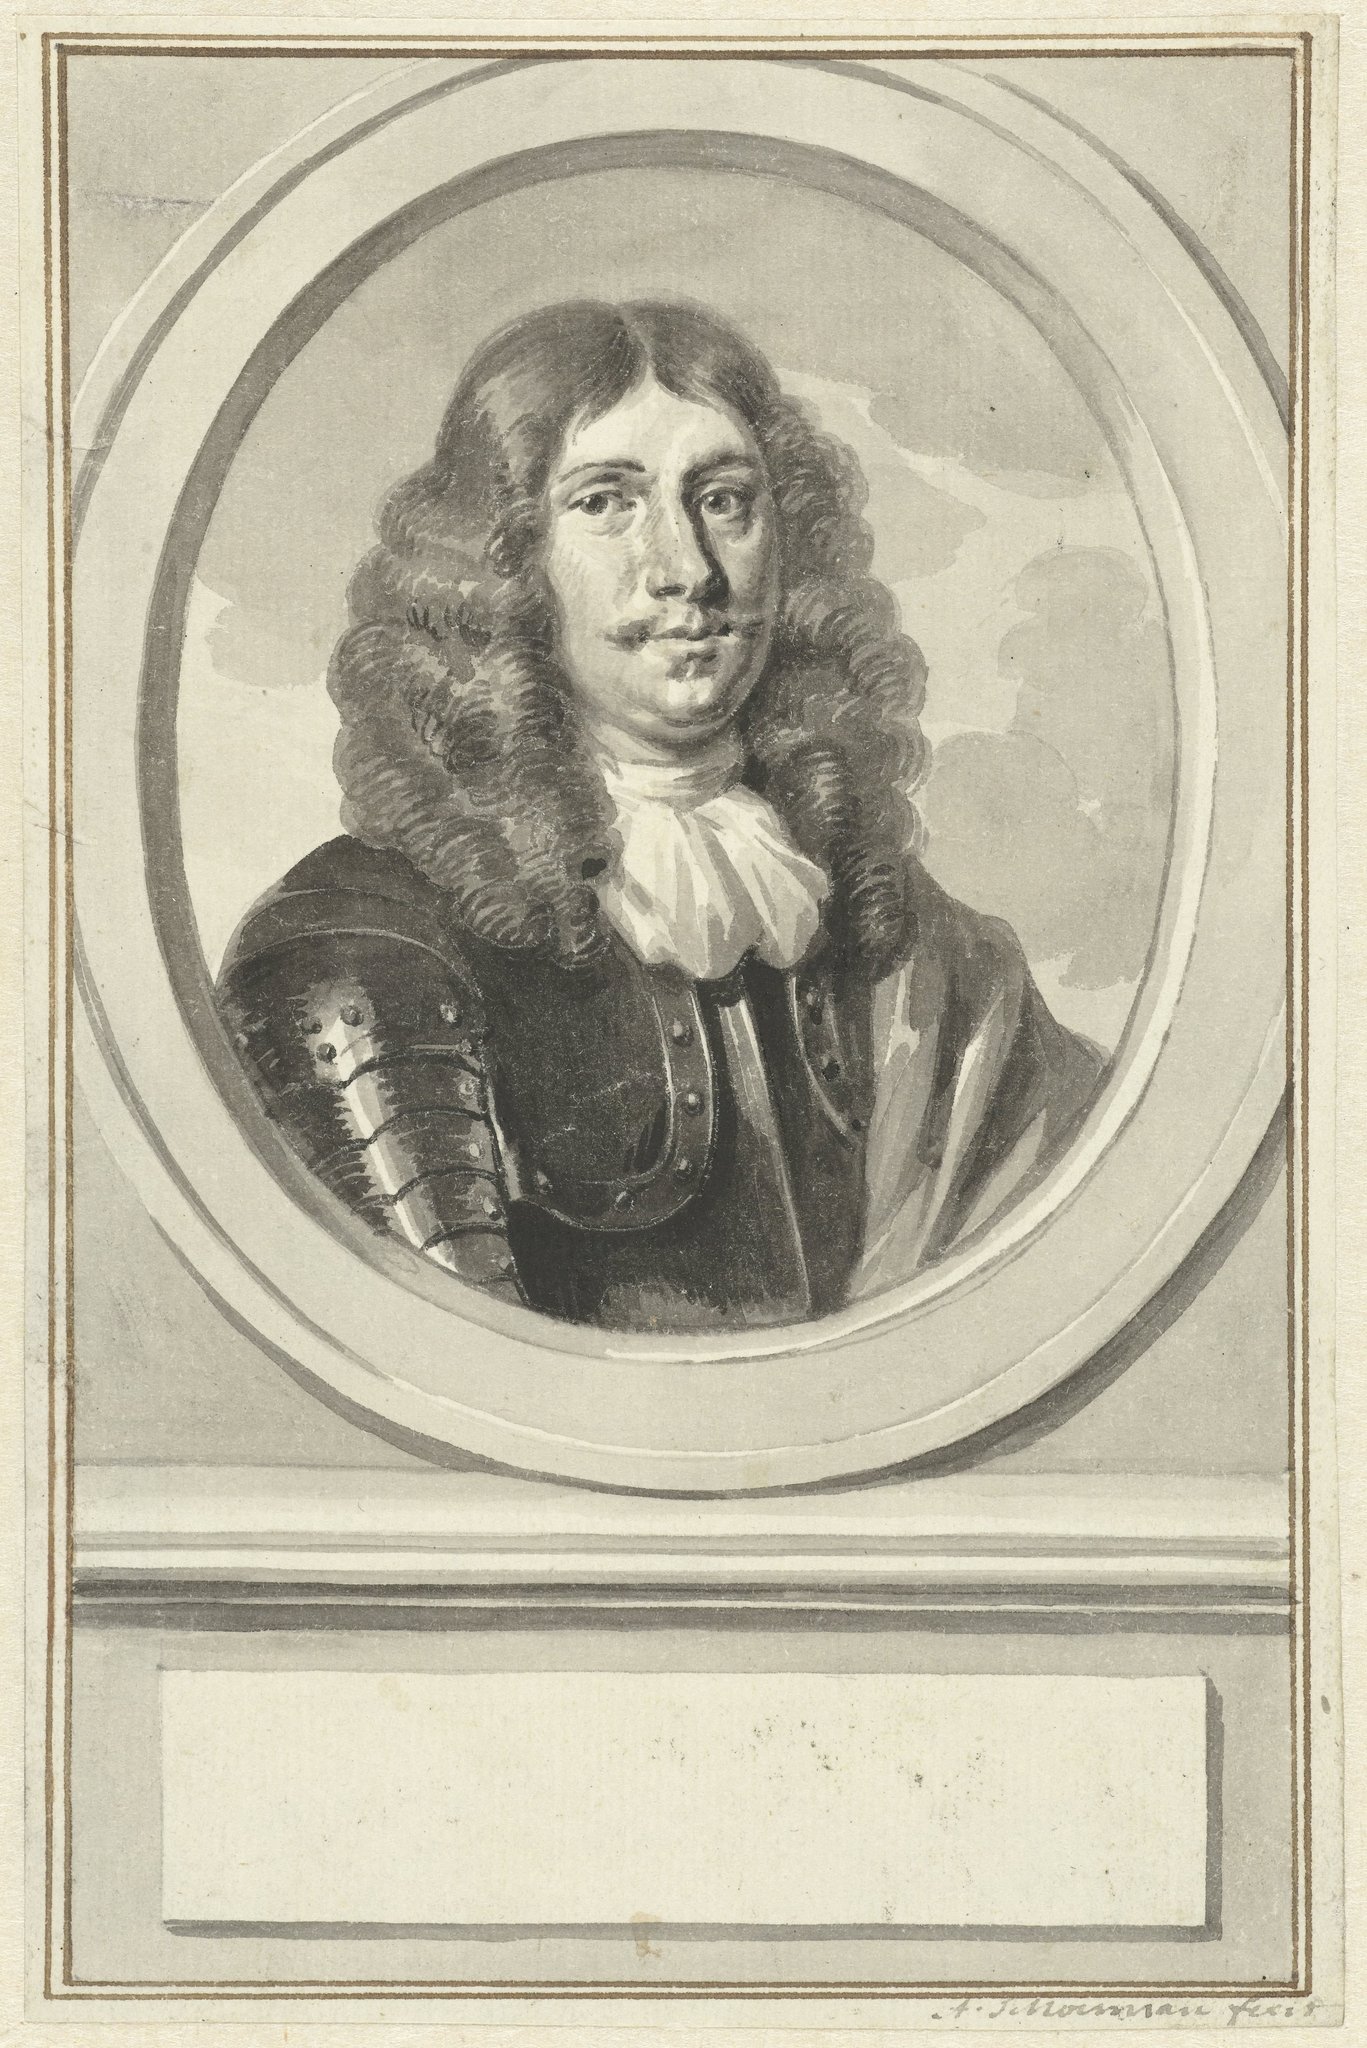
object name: drawing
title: Portret van Cornelis Evertsen in wapenrusting, in ovaal, naar rechts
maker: aert schouman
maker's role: draughtsman, painter, print maker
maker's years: 1710-1792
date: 1720-1792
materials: ink, paper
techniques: brush, pen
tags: historical persons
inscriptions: inscription: ‘Cornelis Evertsen’